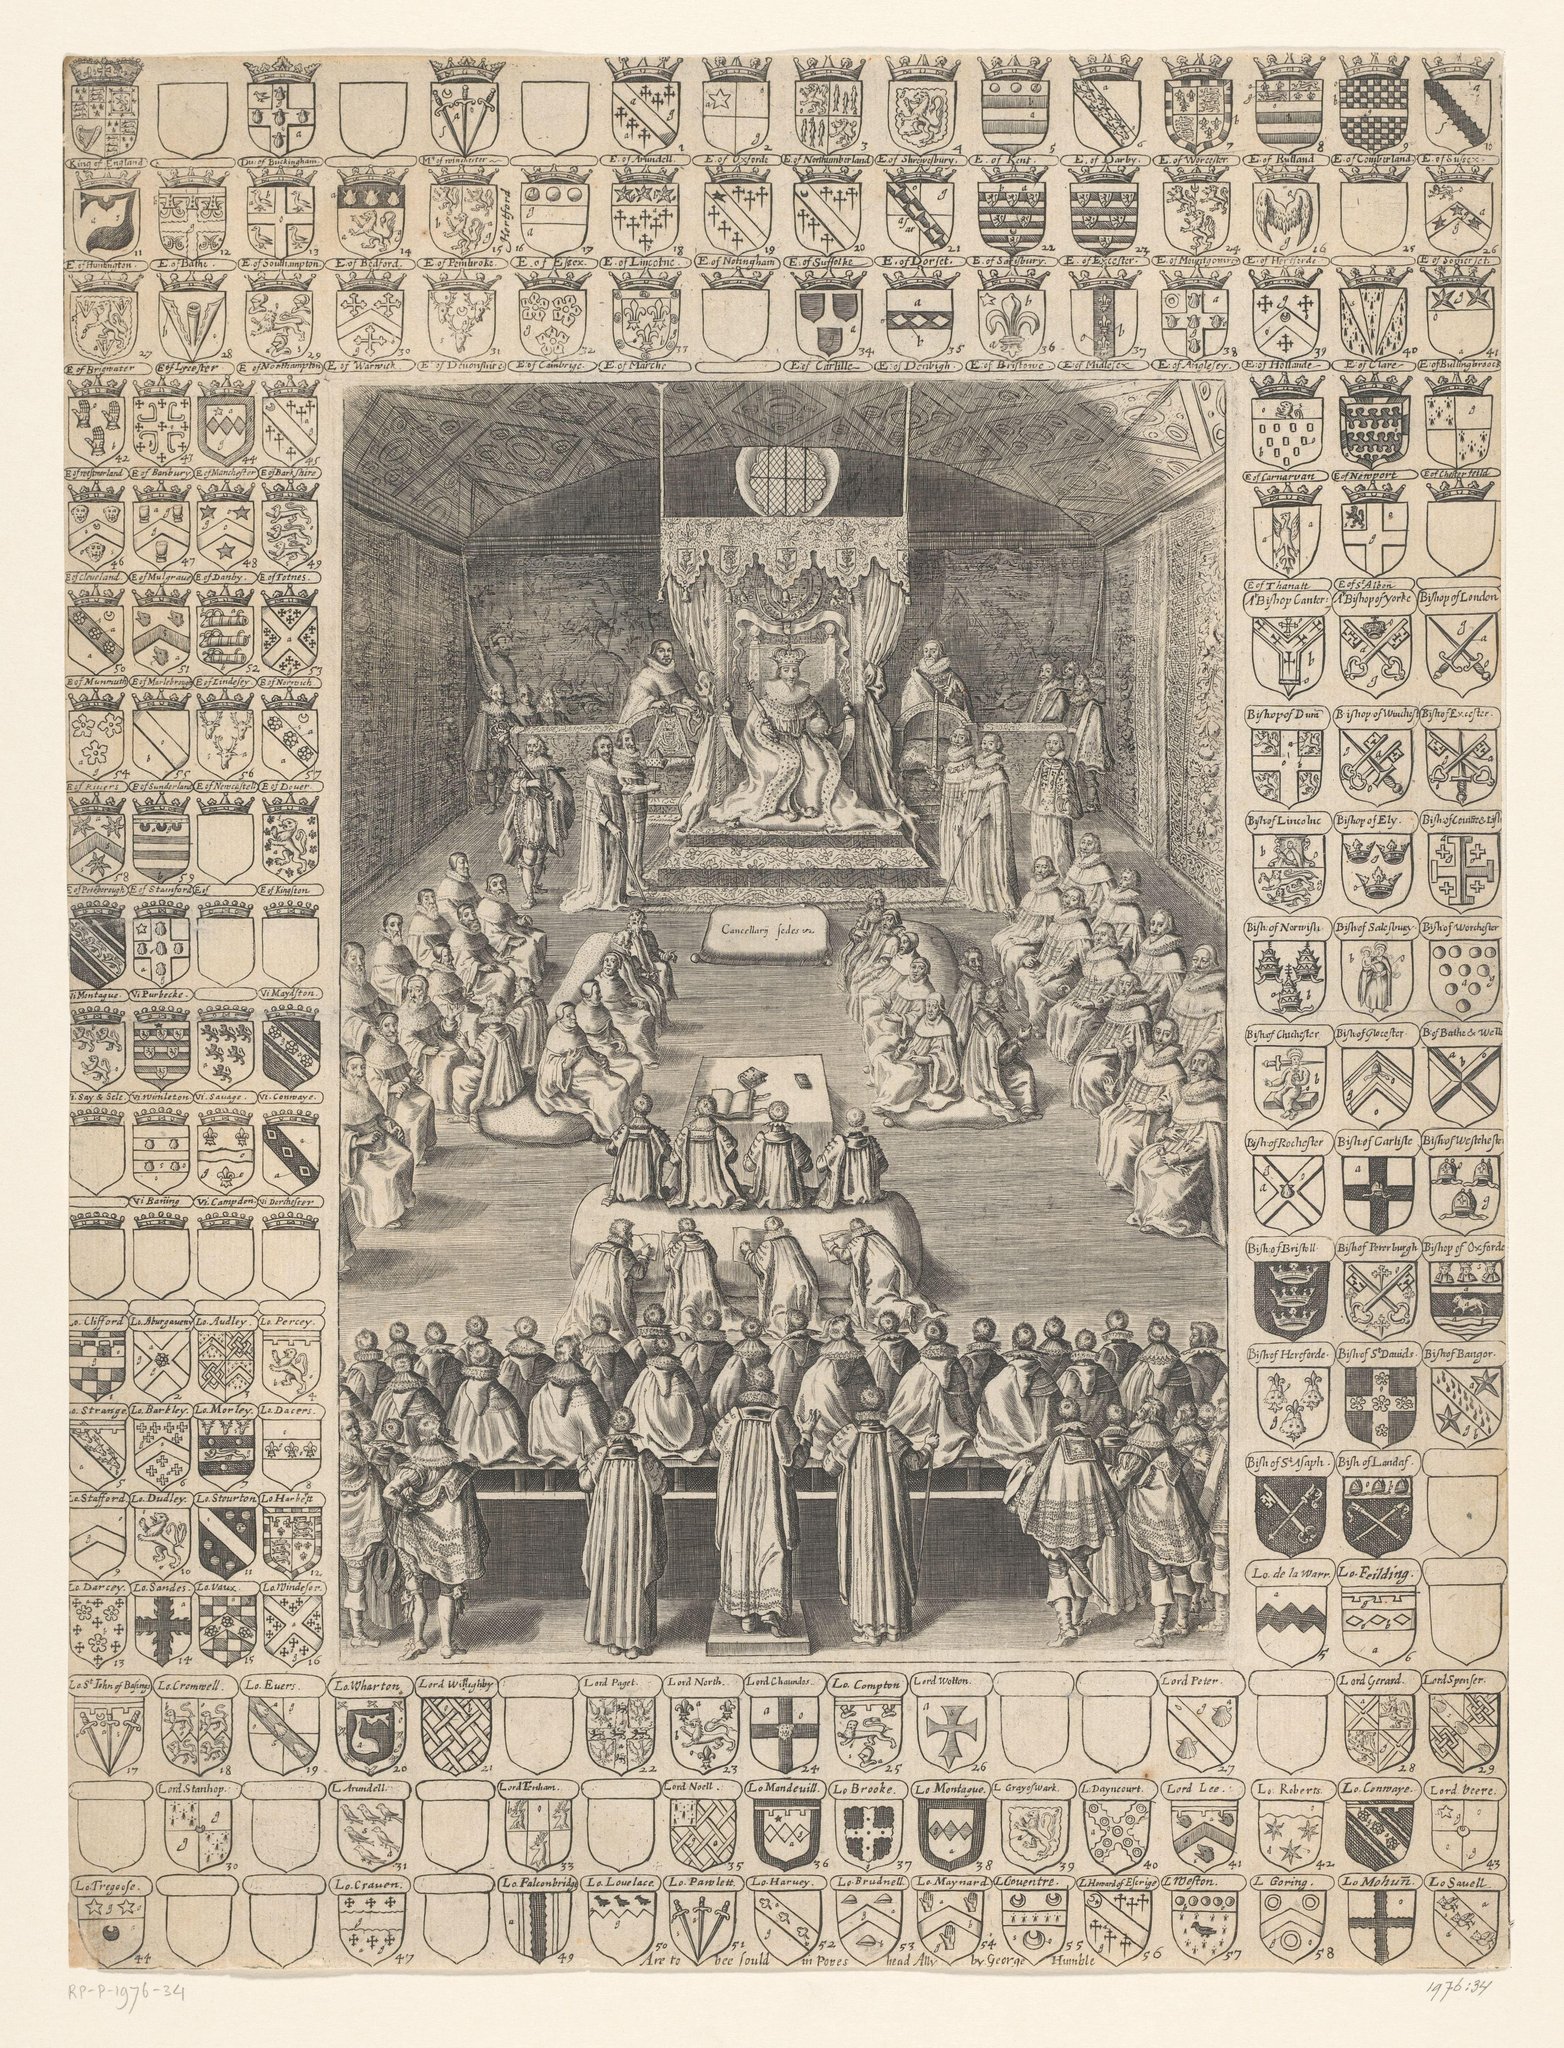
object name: print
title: Karel I opent de zitting van het Parlement, 1628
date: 1628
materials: paper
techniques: engraving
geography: london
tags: london, karel i (koning van engeland), official acts of rulers, e.g. royal acts (ruler giving audience, granting mercy, etc.; ruler and his subjects), upper house, senate, lower house, parliament, chamber, armorial bearing, heraldry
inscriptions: collector's mark: Lugt 2228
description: Koning Karel I van Engeland opent de zitting van het Parlement, 1628. De koning gezeten op zijn troon, links en rechts en op de voorgrond de leden van het Parlement. Deze plaat omringd door rijen (deels oningevulde) heraldische wapens van de parlementsleden.